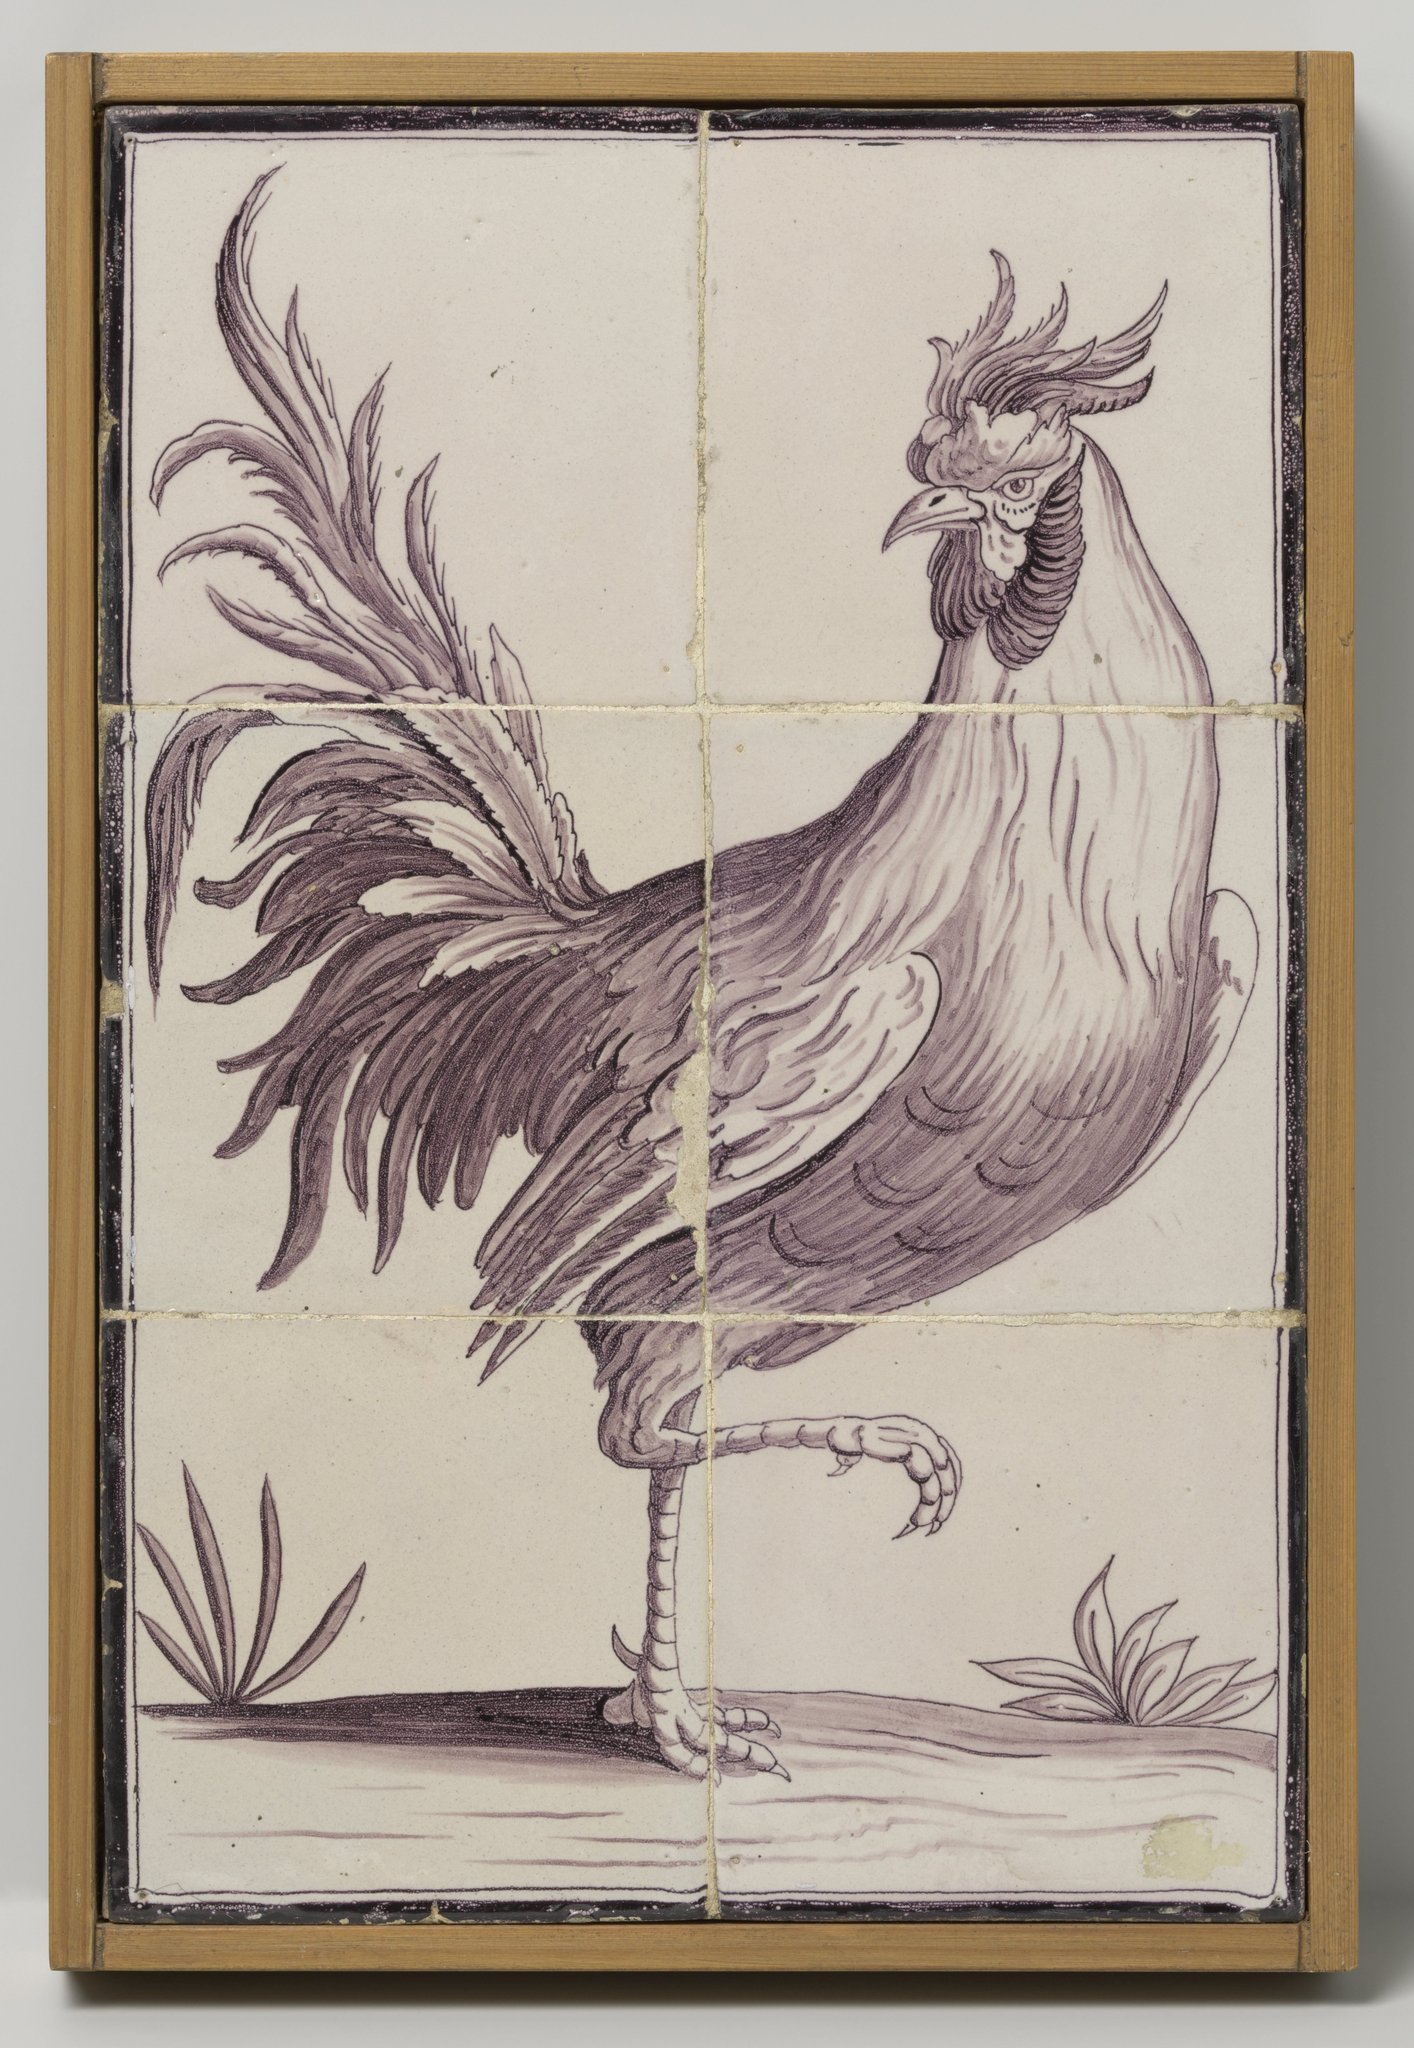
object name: tile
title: Tegeltableau van een haan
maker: Anonymous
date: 1760-1820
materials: earthenware, glaze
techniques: maiolica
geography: netherlands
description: Tegeltableau van zes tegels (3 x 2) met een paars geschilderde haan staande op één poot.